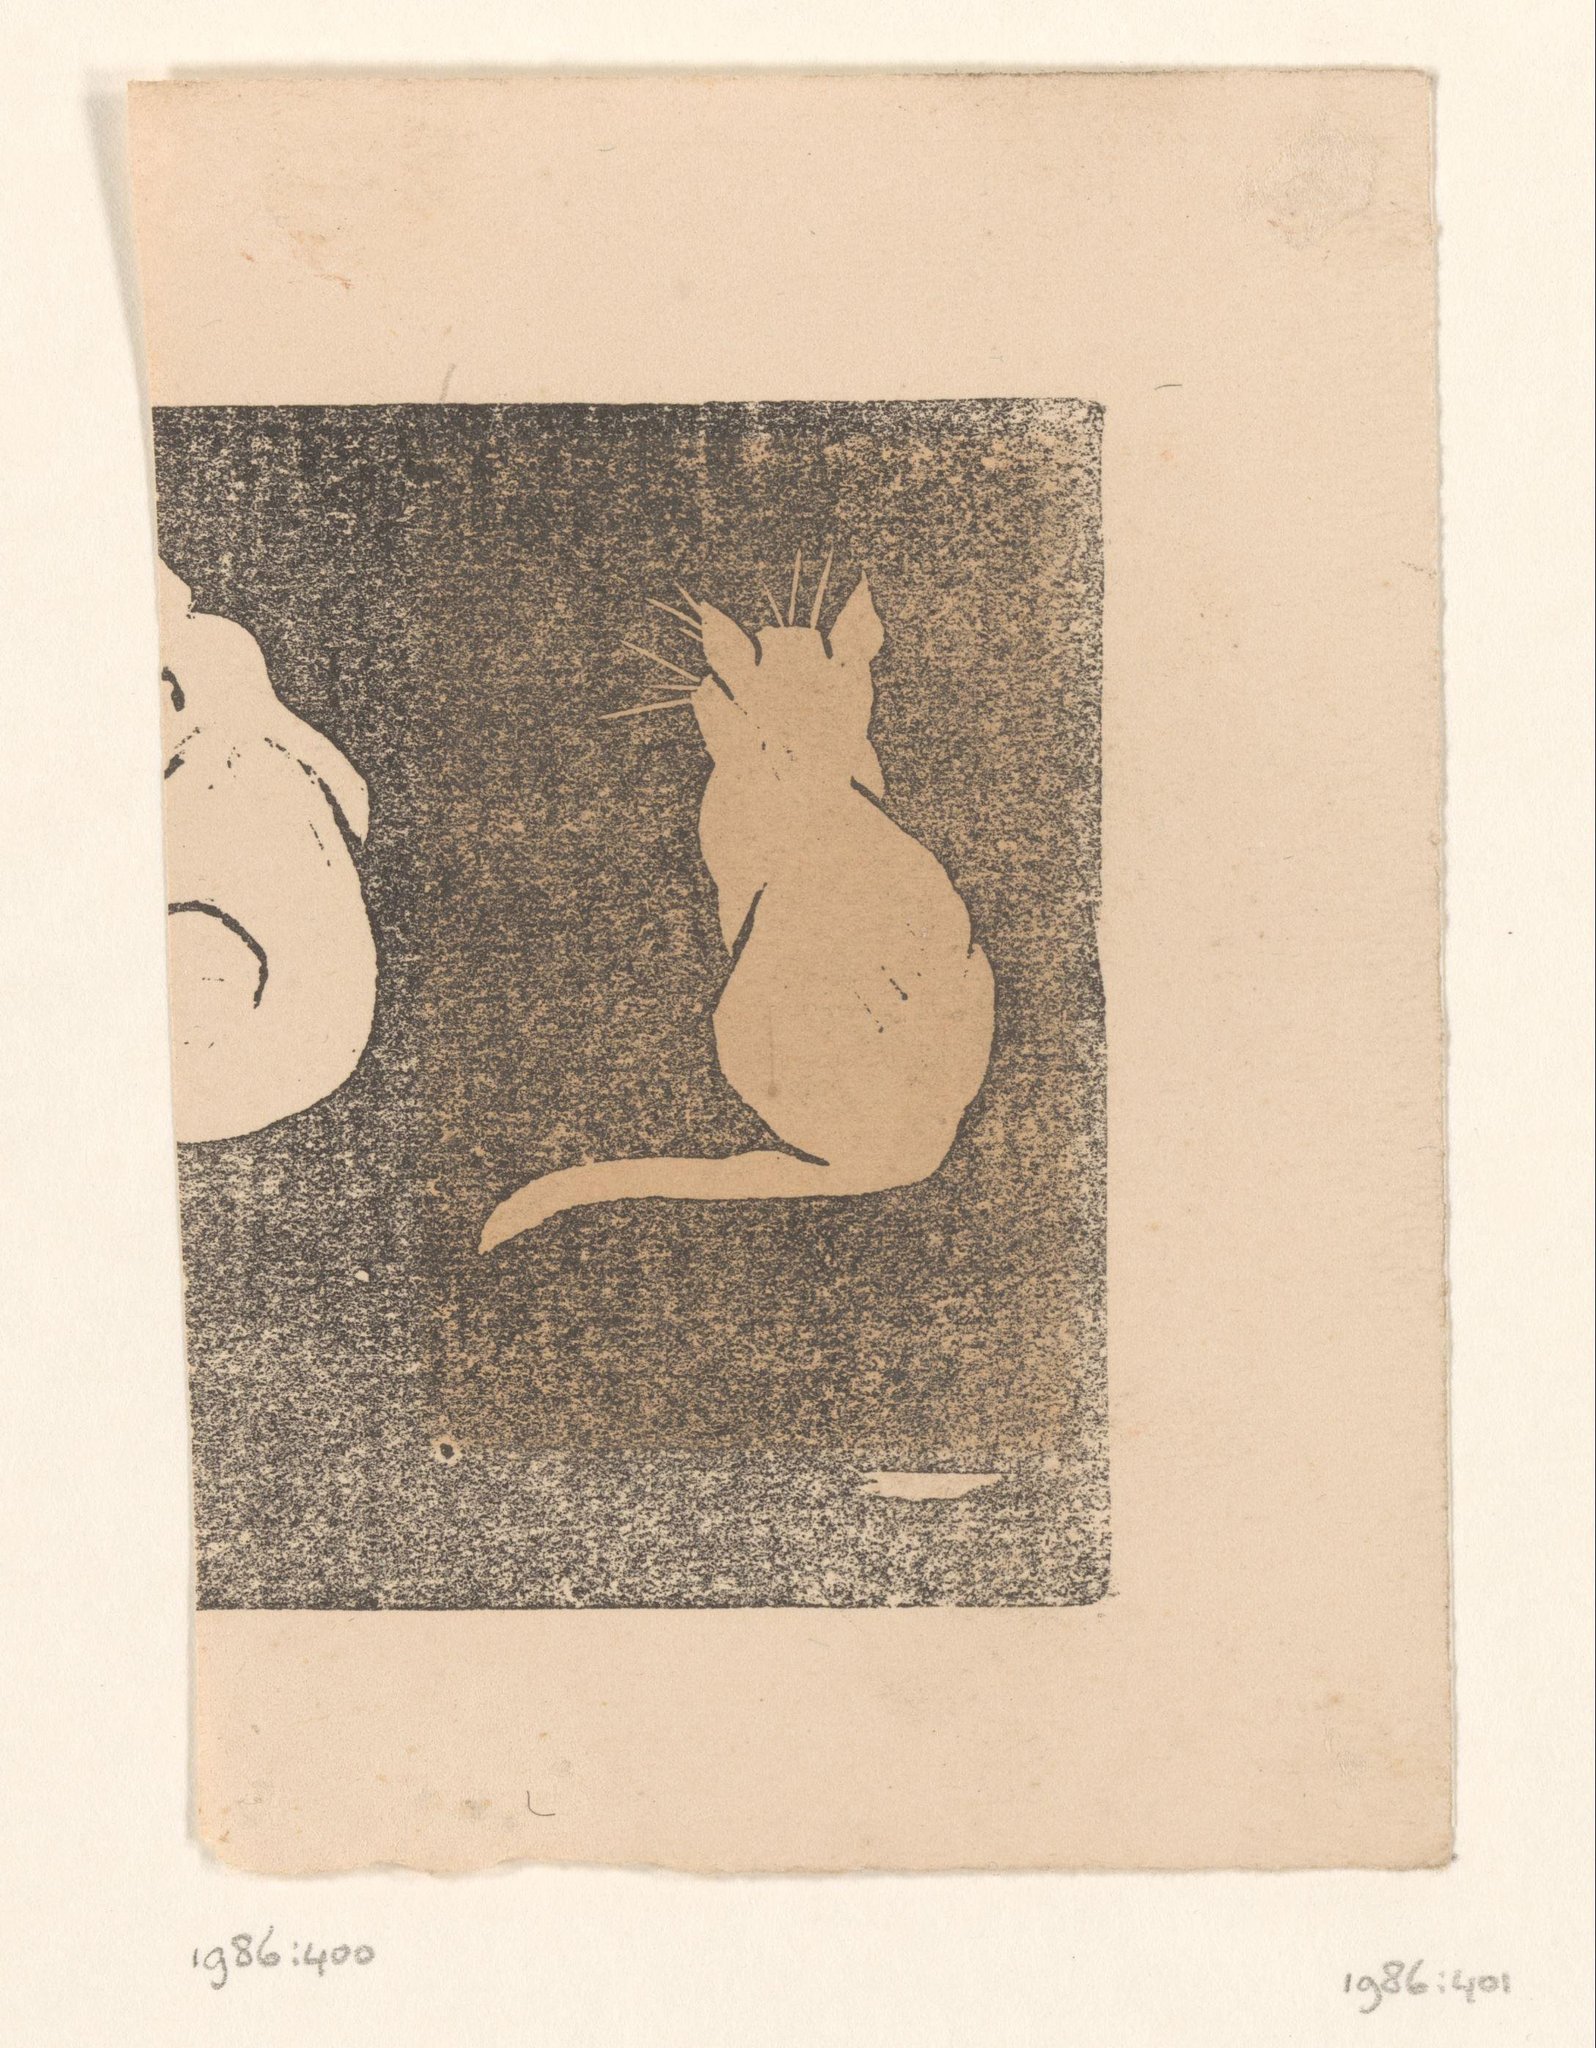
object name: print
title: Kat op de rug gezien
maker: reinier willem petrus de vries (1874-1953)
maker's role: draughtsman, print maker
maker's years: 1874-1953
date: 1884-1952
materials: paper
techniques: linocut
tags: cat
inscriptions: collector's mark: Lugt 2228